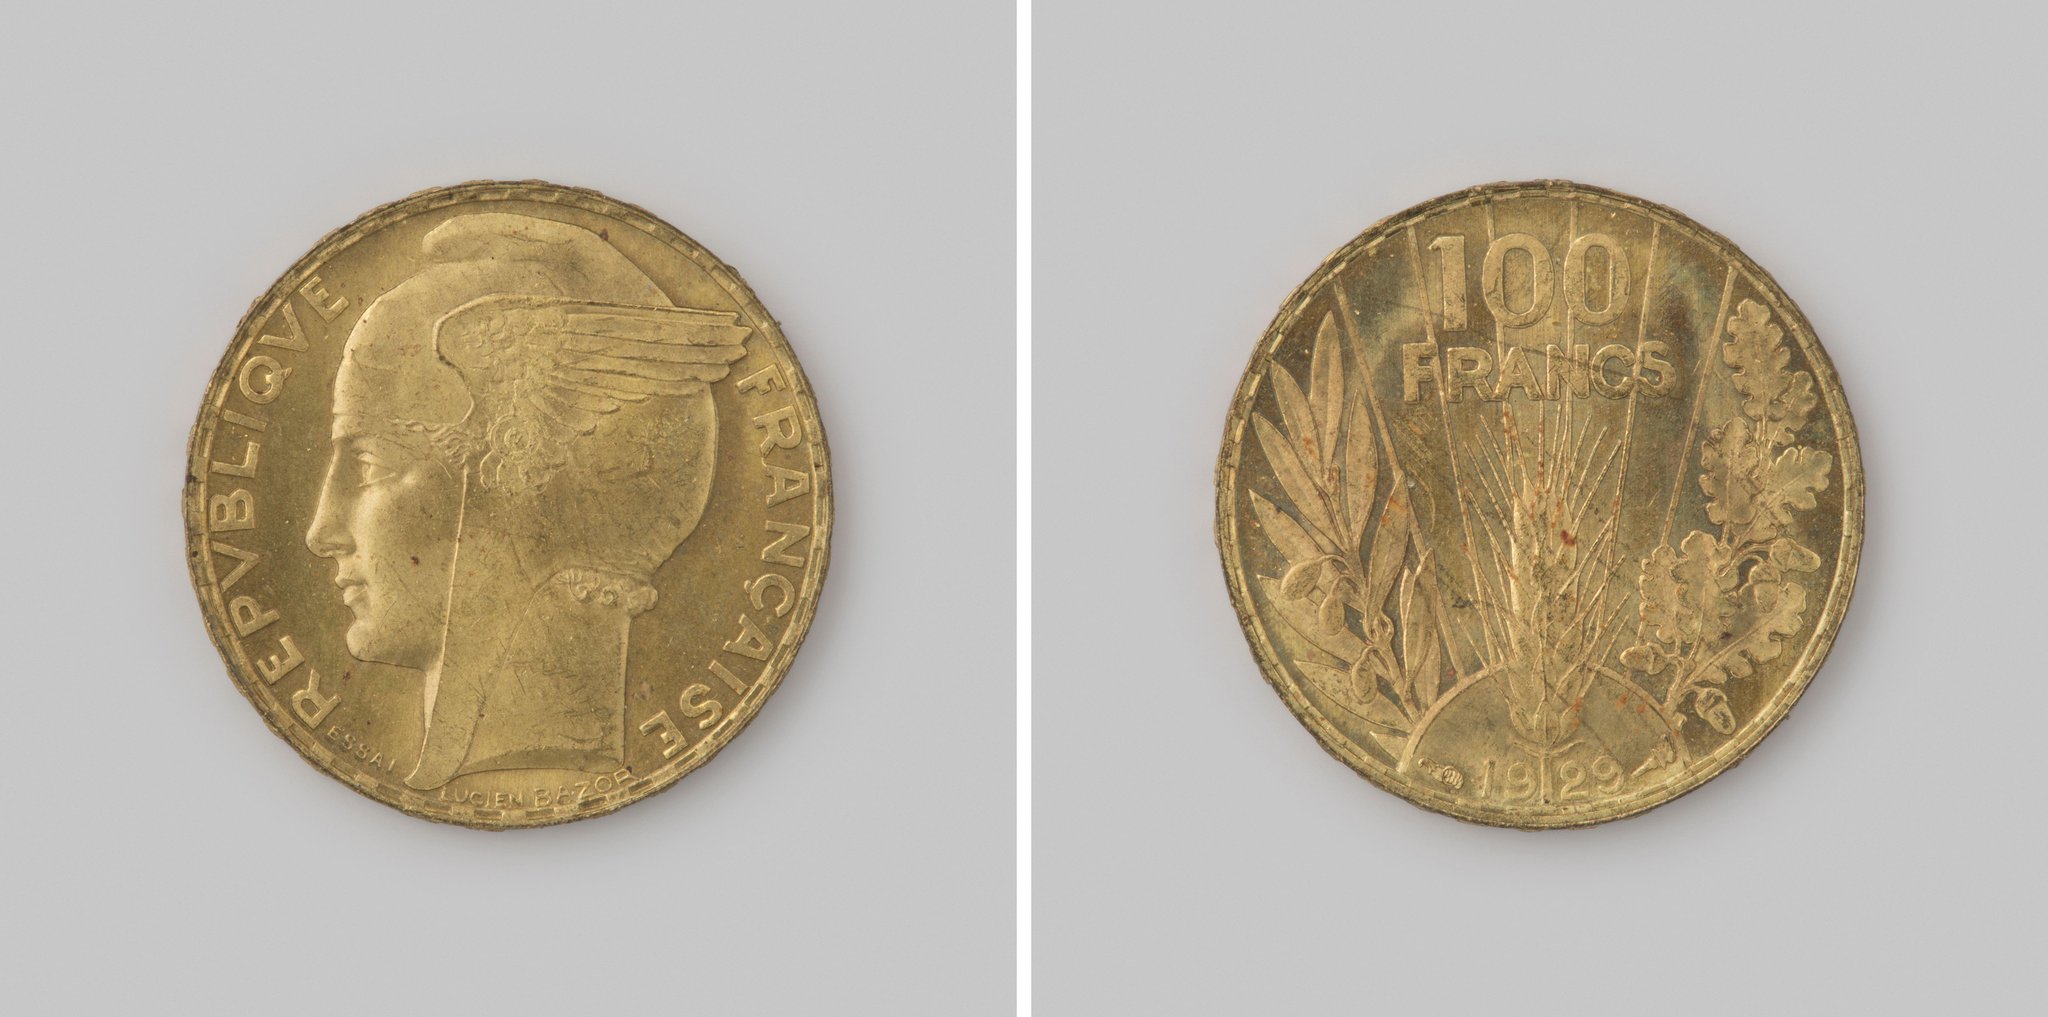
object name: honderd franc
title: Proef (essai) voor een munt van 100 francs uit Frankrijk, de Derde Republiek, 1929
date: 1929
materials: bronze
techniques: striking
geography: paris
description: Proef in aluminium-brons voor een gouden 100 francs-stuk van de ontwerper L. Bazor. Voorzijde: hoofd van een vrouw met vrijheidshoed, waarop een vleugel, naar links. Keerzijde: een eiken- en een lauriertak, waartussen een korenaar. Daarboven waarde-aanduiding in twee regels. Jaartal onderaan. Randschrift.